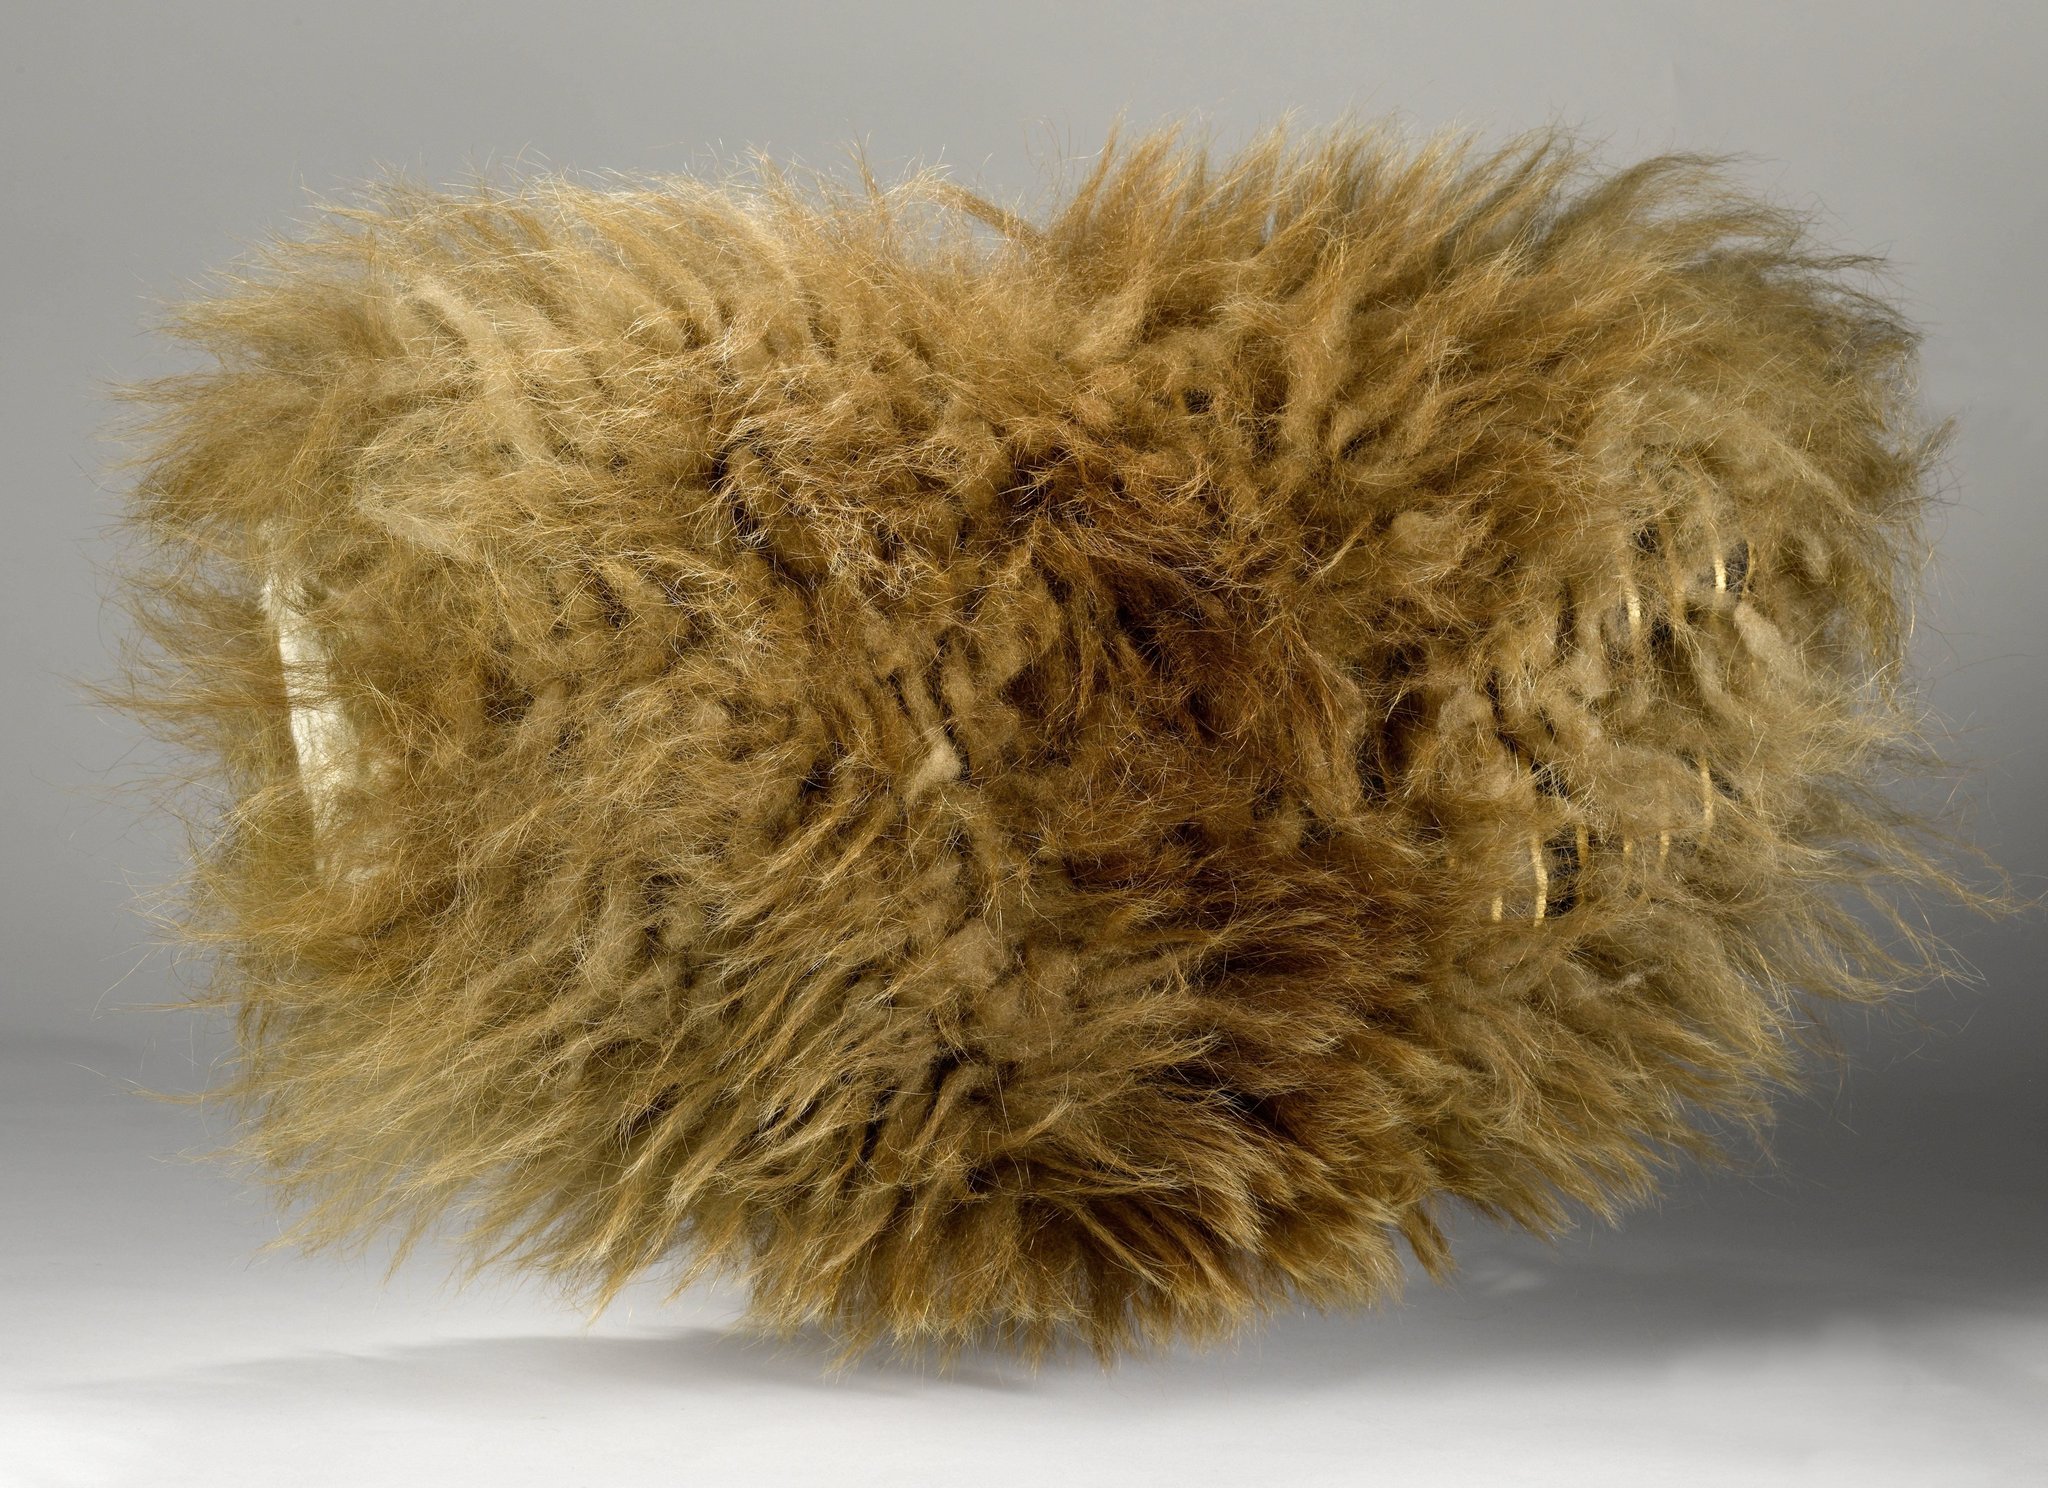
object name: muff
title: Mof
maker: Anonymous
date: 1780-1795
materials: fur, textile, silk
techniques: sewing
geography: netherlands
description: Nadat het dragen van een grote mof vlak voor de Franse revolutie voor vrouwen in de mode kwam werd het in de tweede helft van de jaren 1790 ook voor heren gebruikelijk. Dit model is gemaakt van langharig bont en gevoerd met zijde.